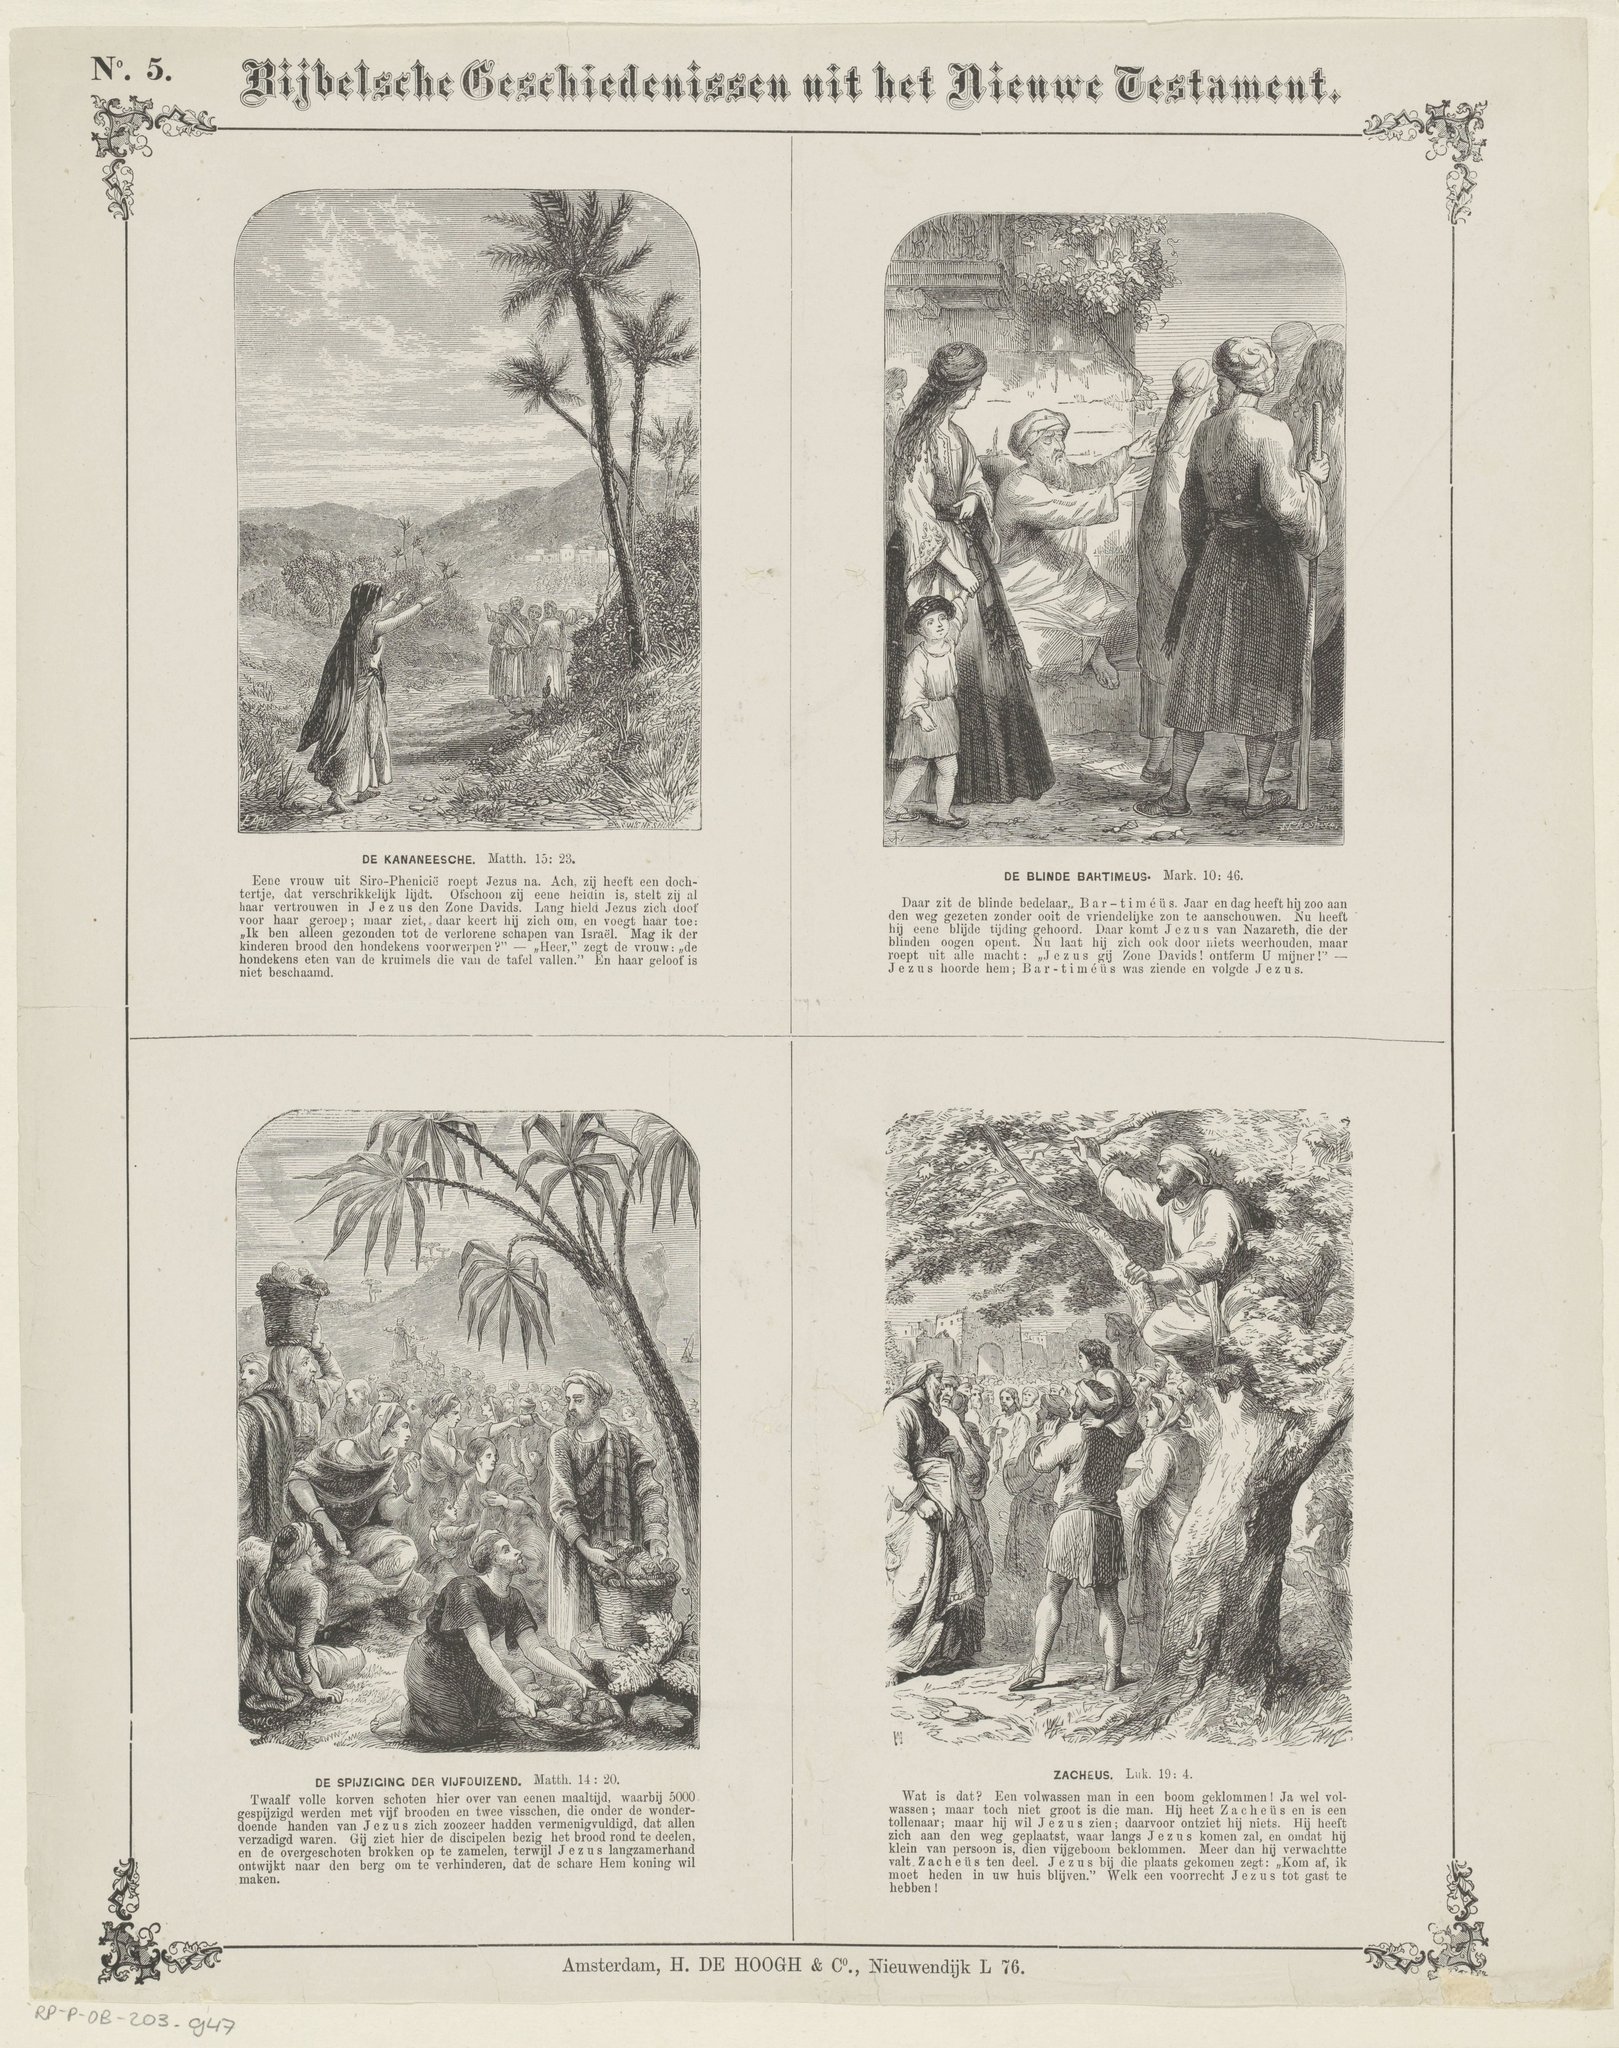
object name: print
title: Bijbelsche geschiedenissen uit het Nieuwe Testament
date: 1866-1871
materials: paper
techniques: letterpress printing, engraving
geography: amsterdam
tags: multiplication of loaves and fishes for a multitude of four or five thousand people (matthew 14:13-21, 15:32-39; mark 6:32-44, 8:1-10; luke 9:10-17; john 6:1-14), a canaanite woman kneels before christ, asking him to heal her daughter; the metaphor of the dogs and bread (matthew 15:21-28; mark 7:24-30), calling of zacchaeus, who is sitting in a fig-tree (christ passing through jericho), healing of two blind men, or one (bartimaeus), sitting near jericho (matthew 20:29-34; mark 10:46-52; luke 18:35-43), new testament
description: Blad met 4 voorstellingen van verhalen uit het Nieuwe Testament. De Kananeesche vrouw, de blinde Bartimeüs, de spijziging van vijfduizend en Zacheüs in een vijgenboom. Onder elke afbeelding de bijbehorende Bijbeltekst. Genummerd linksboven: No. 5.